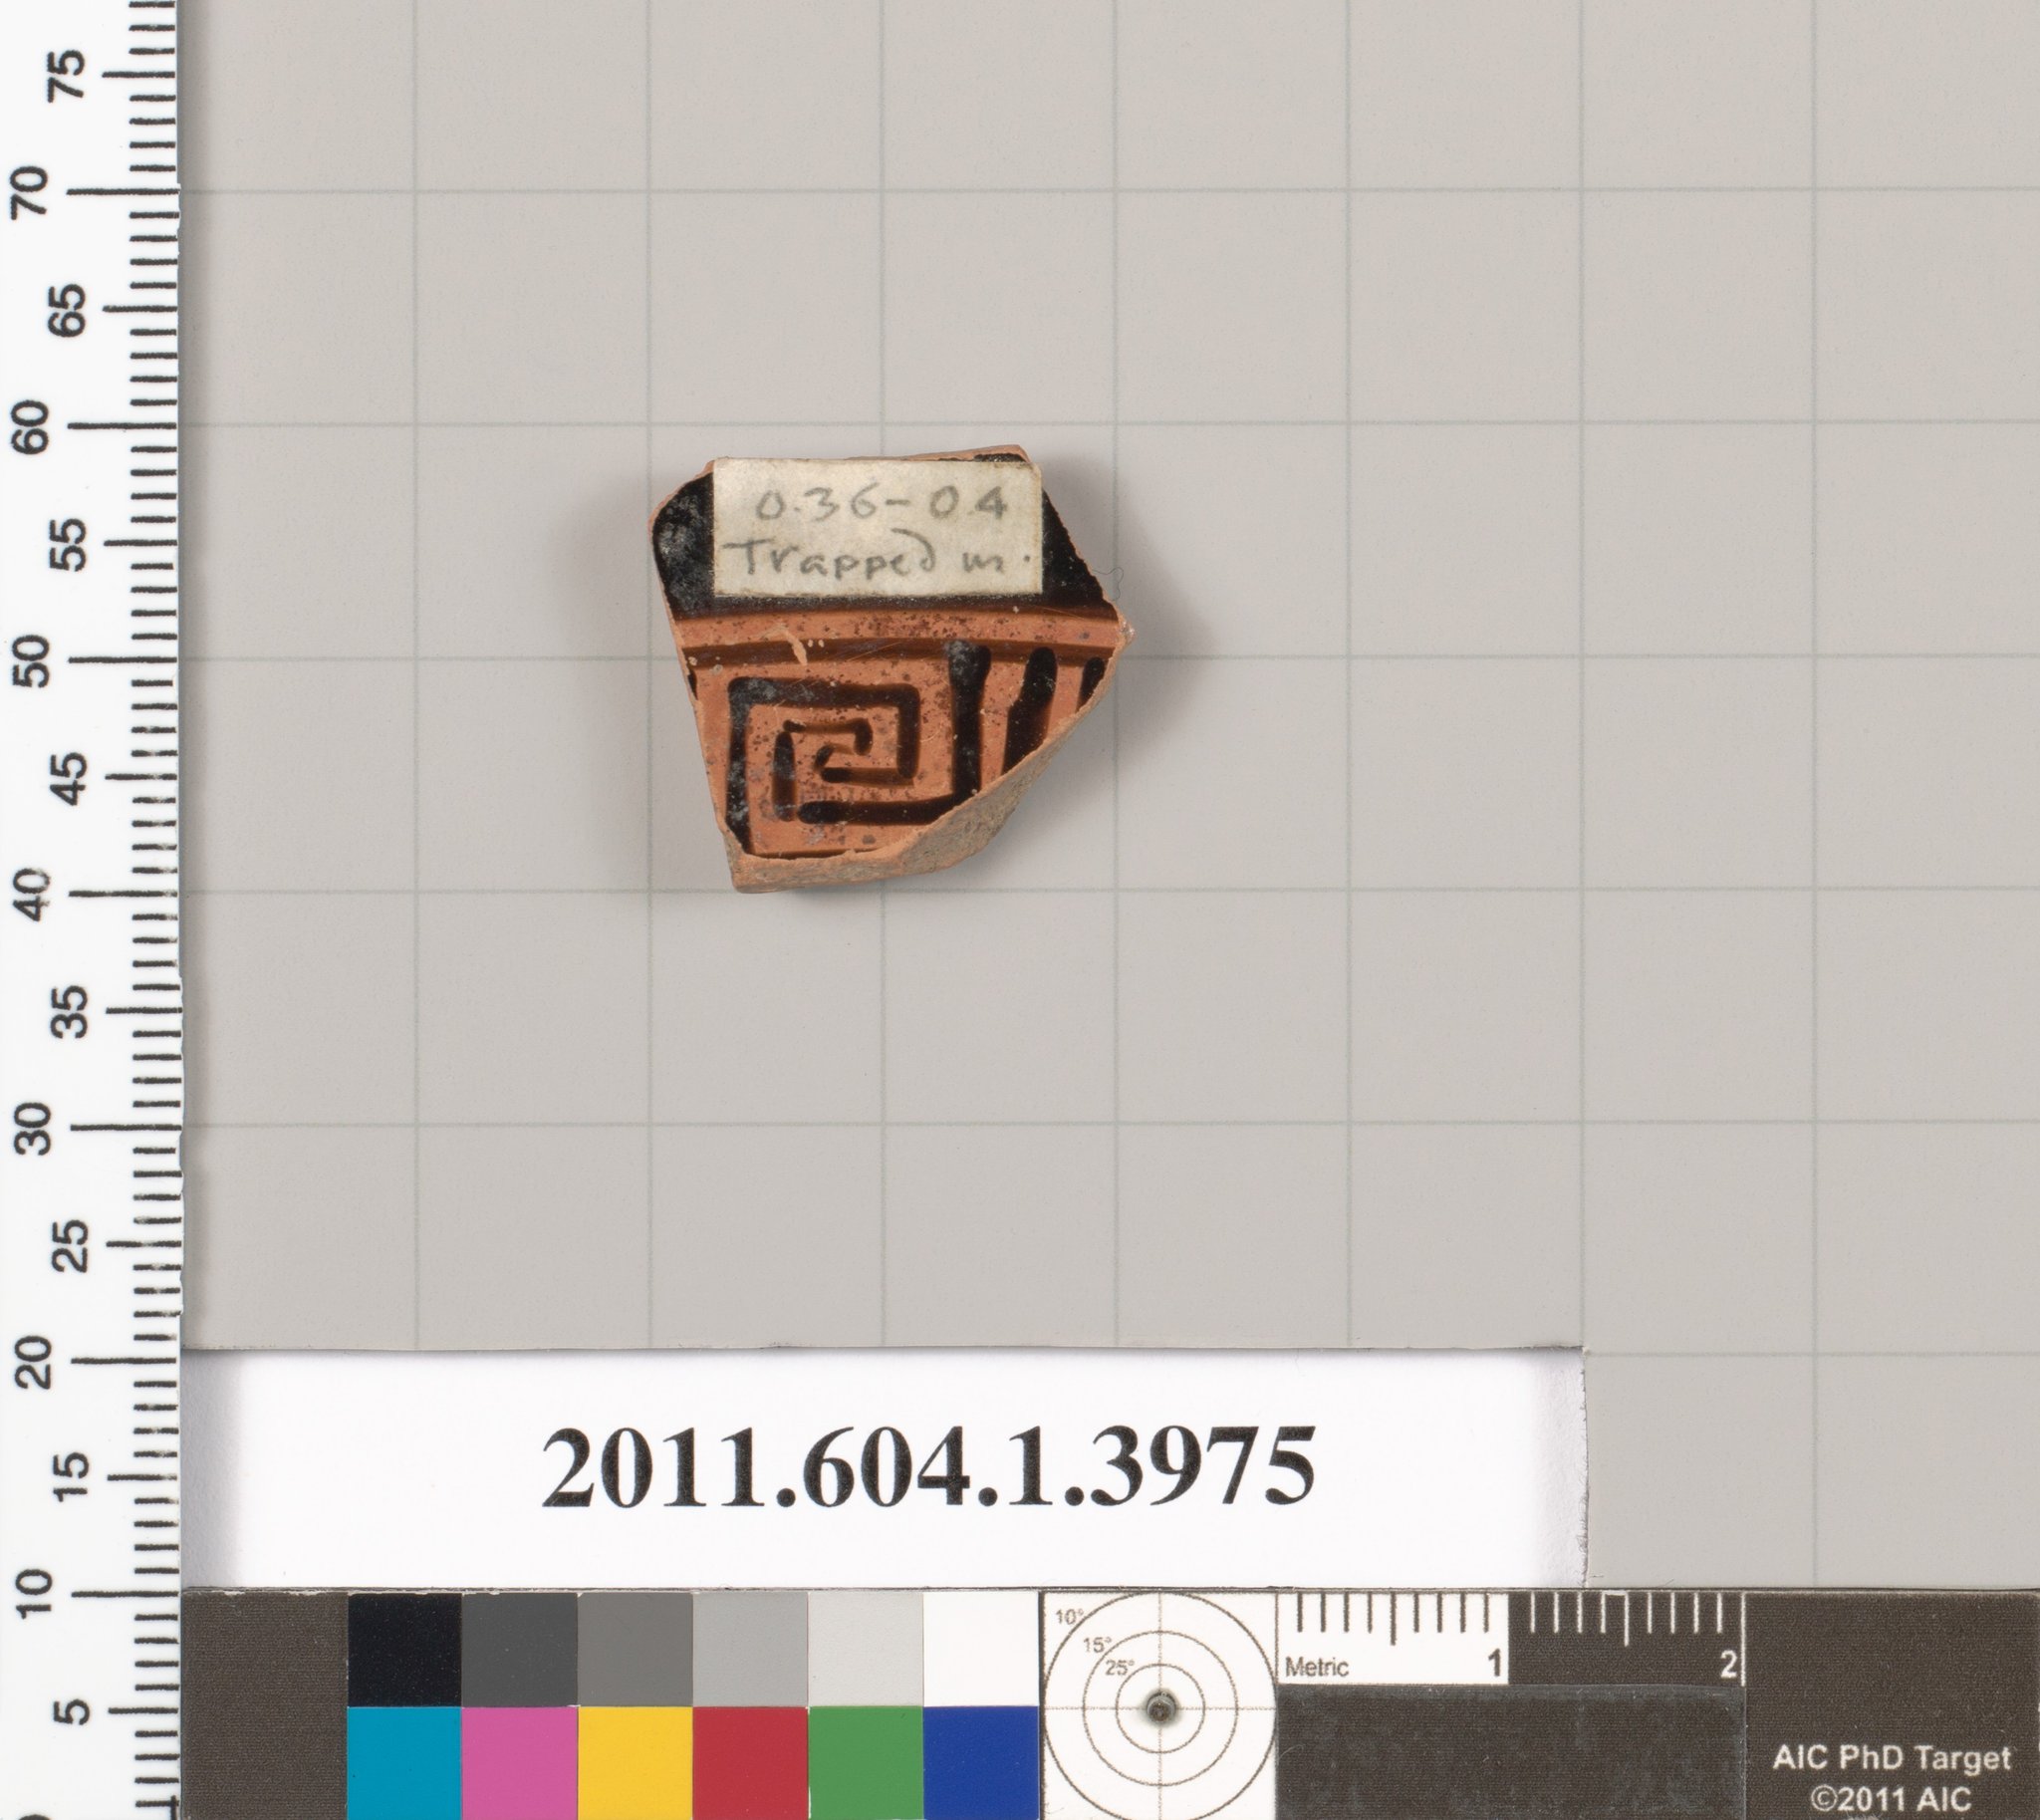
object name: kylix fragment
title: Terracotta fragment of a kylix (drinking cup)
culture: greek, attic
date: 490-470 BCE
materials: terracotta